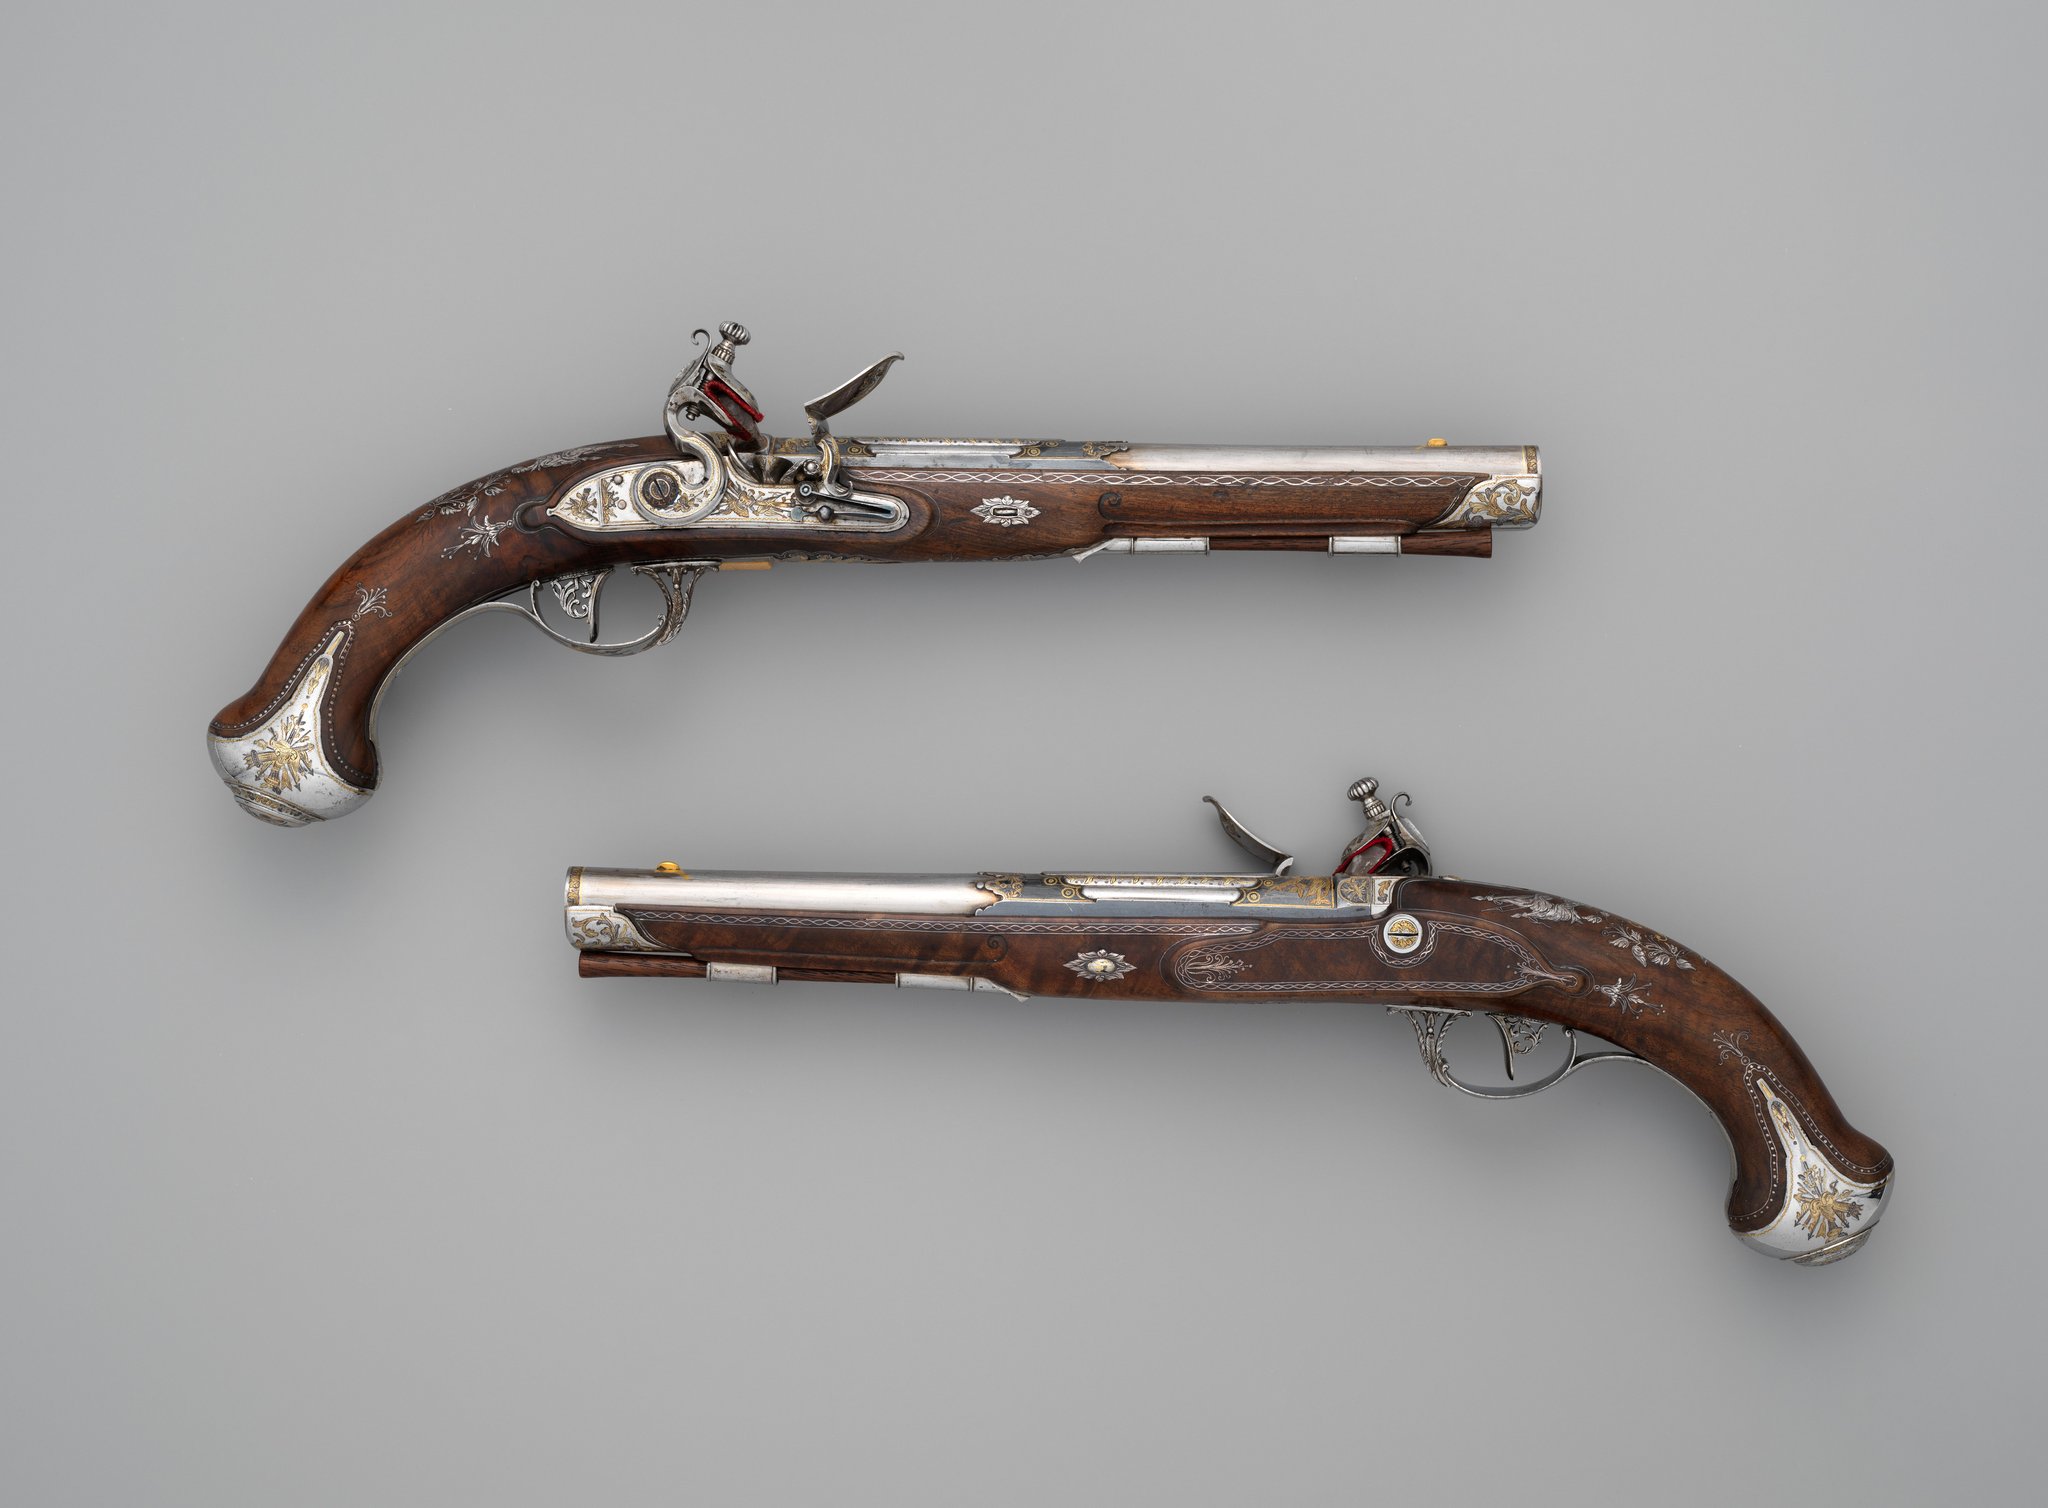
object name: pair of flintlock pistol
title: Pair of Flintlock Pistols Made for Grand Duke Constantine Pavlovich of Russia (1779–1831)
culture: russian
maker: tula arms factory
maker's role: manufacturer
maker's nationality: russian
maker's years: 1712-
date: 1801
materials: gold, silver, steel, wood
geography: russia